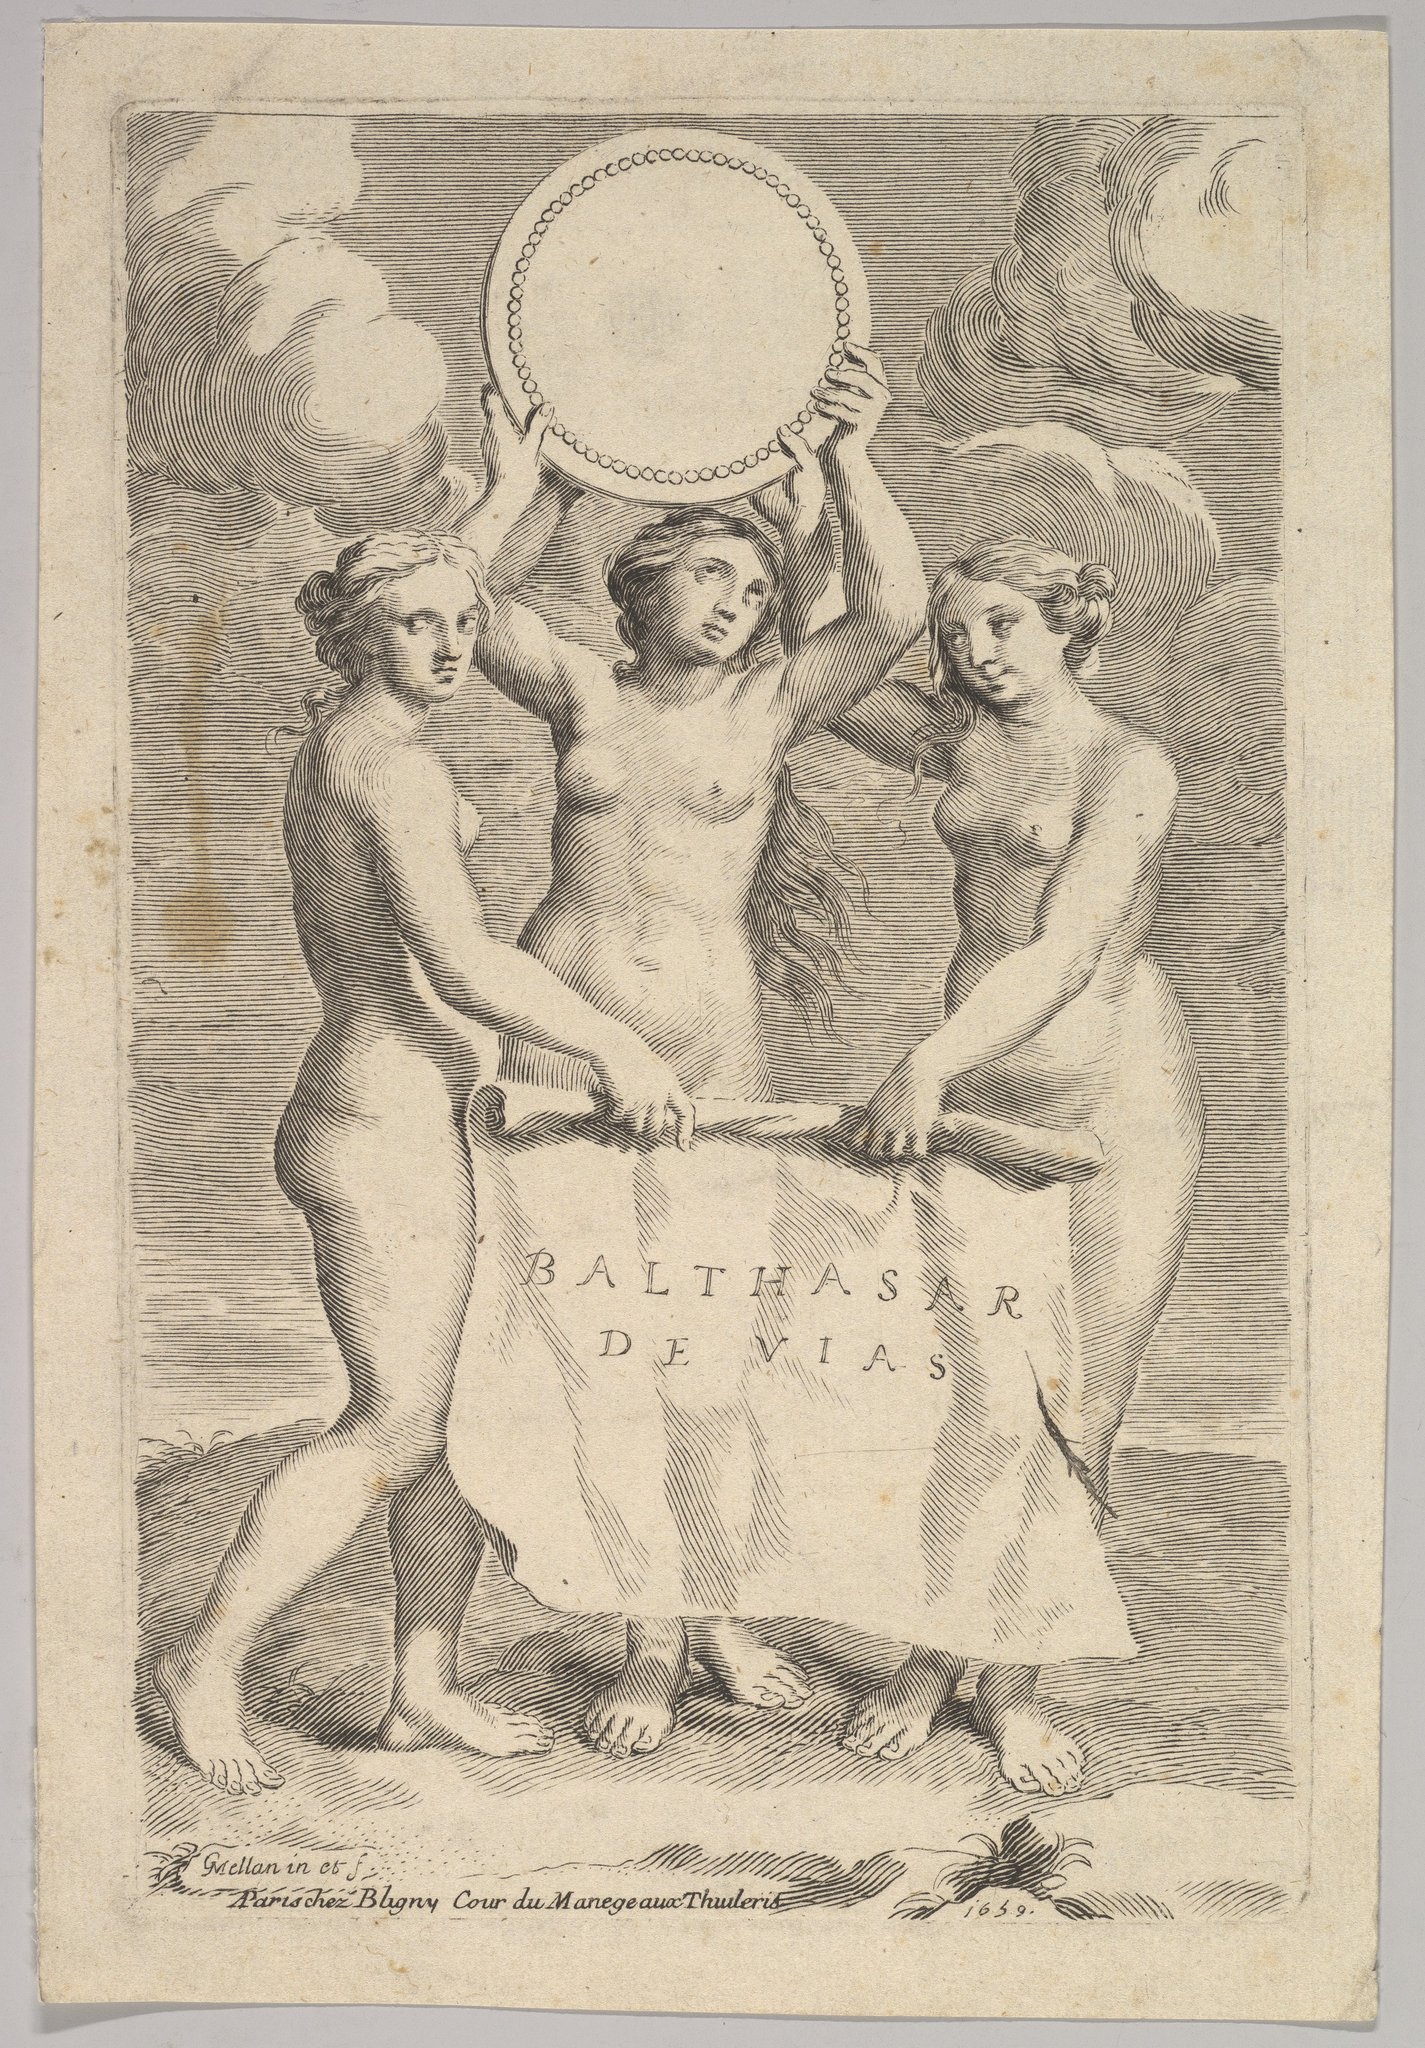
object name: print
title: The Three Graces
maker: claude mellan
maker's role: artist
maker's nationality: french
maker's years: 1598-1688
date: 1659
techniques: engraving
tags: female nudes